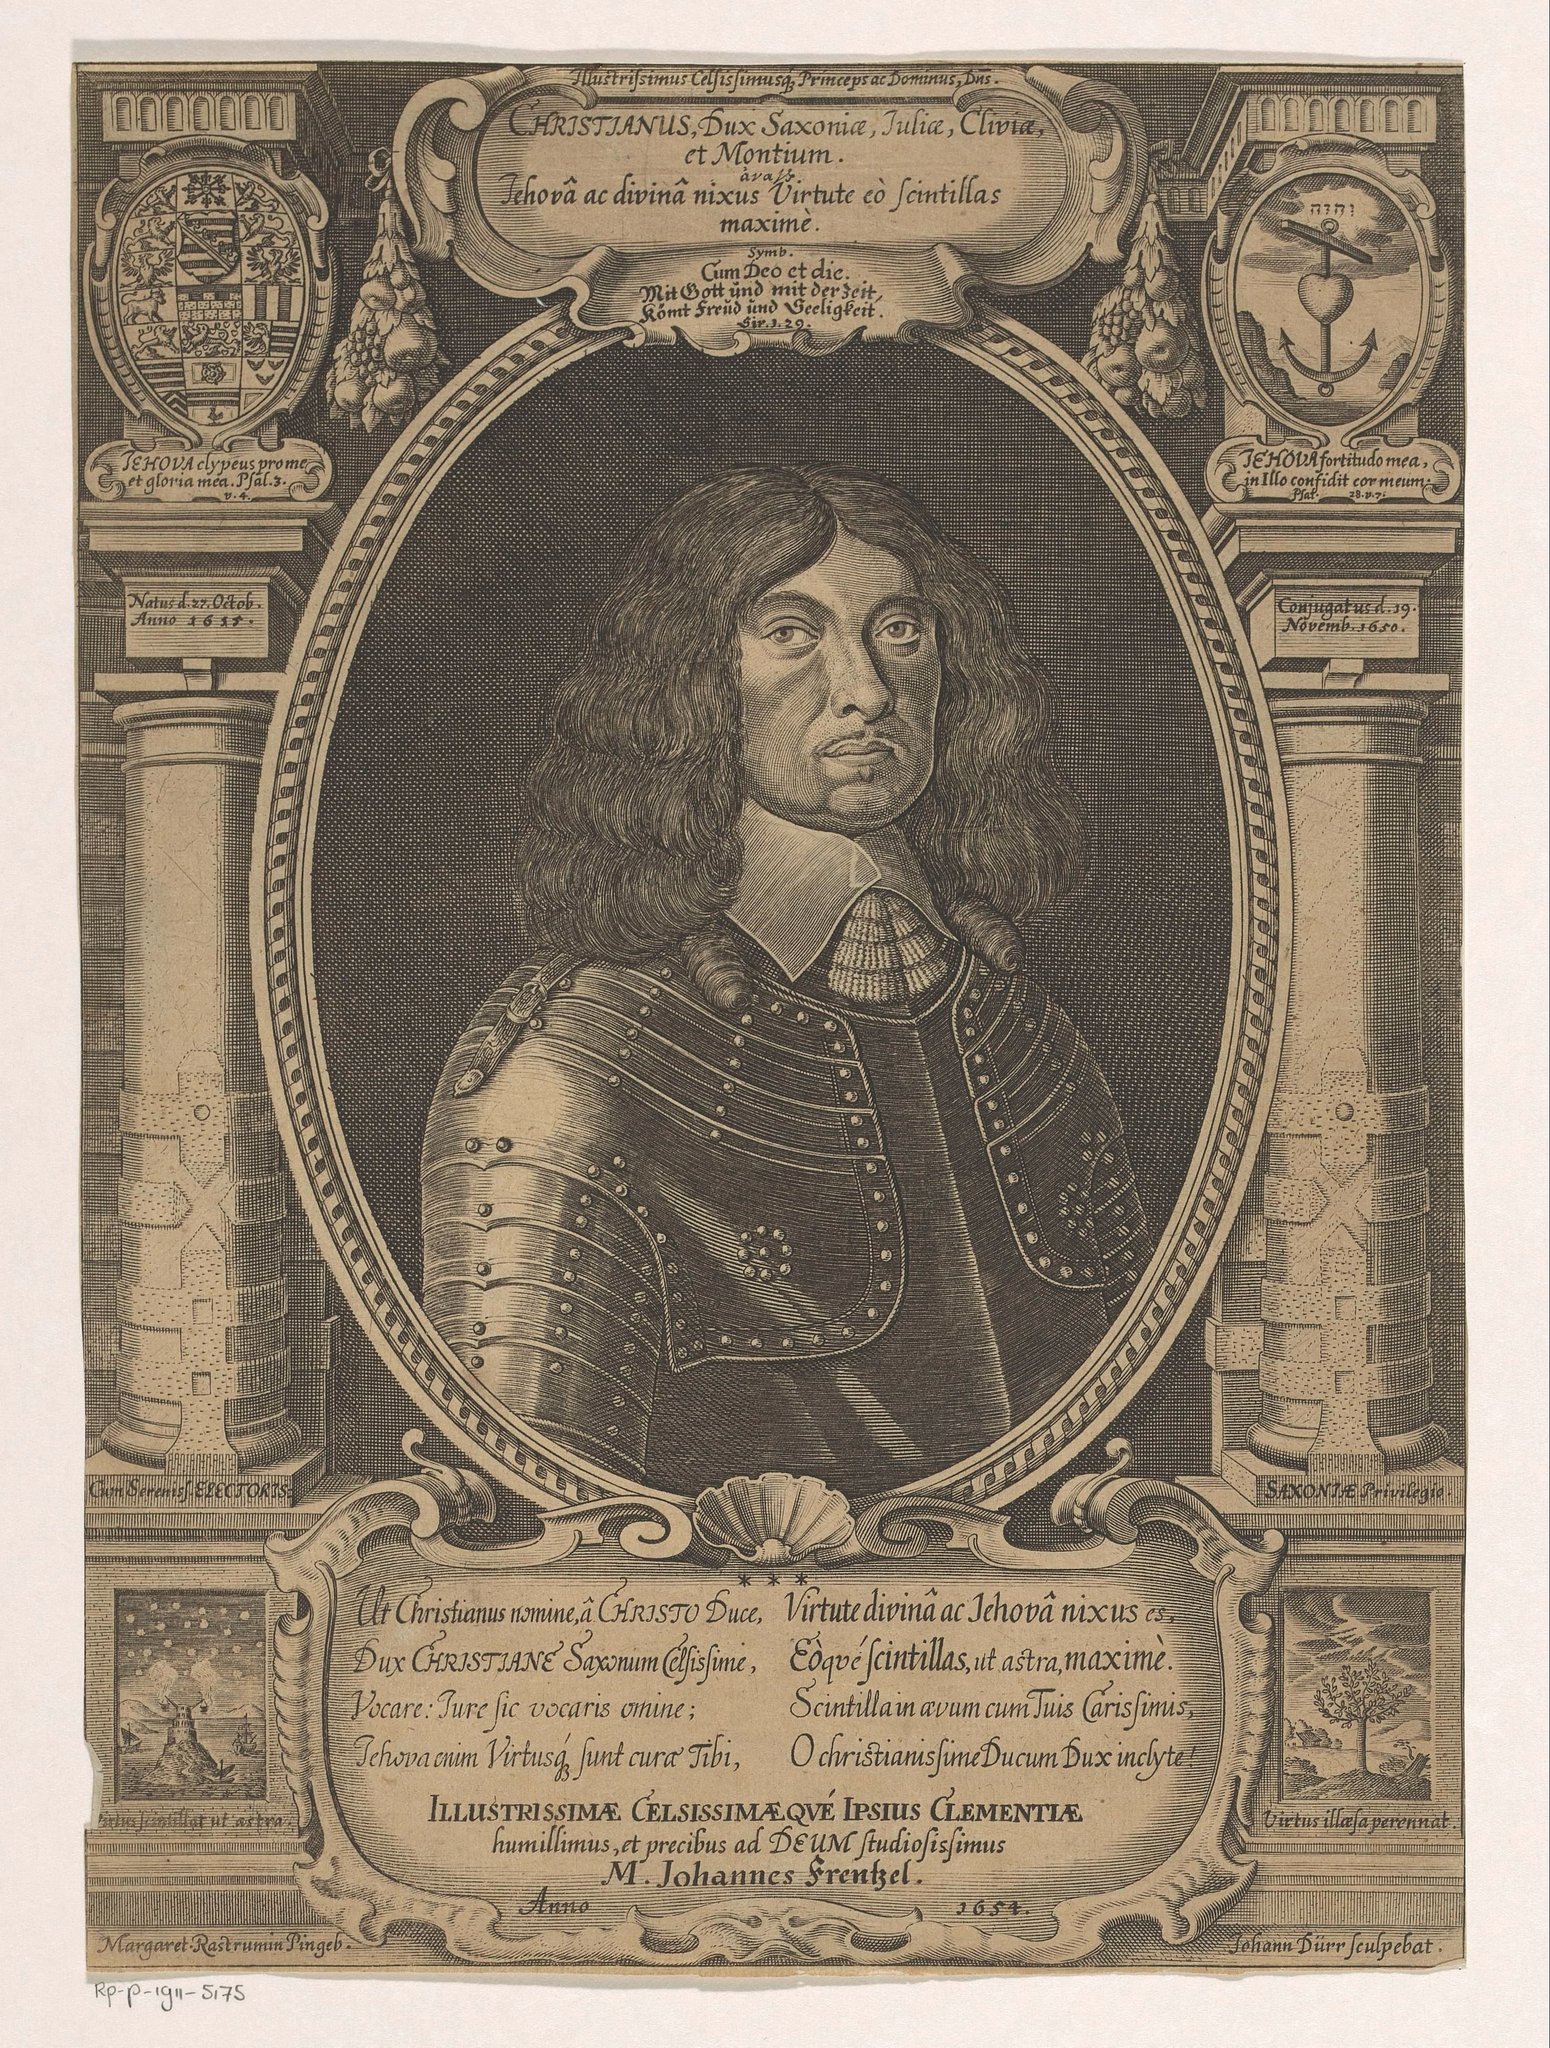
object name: print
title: Portret van Christian I van Saksen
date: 1654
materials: paper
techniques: engraving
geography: germany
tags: the three theological virtues, ornament ~ medallion, armour, historical persons, ornament ~ cartouche, stars, punishment; 'castigo', 'pena', 'punitione' (ripa), armorial bearing, heraldry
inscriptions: collector's mark: Lugt 2228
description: Portret in architecturale omlijsting, met lofdicht in het Latijn. In de hoeken zijn vier motto's en wapenschilden verwerkt.